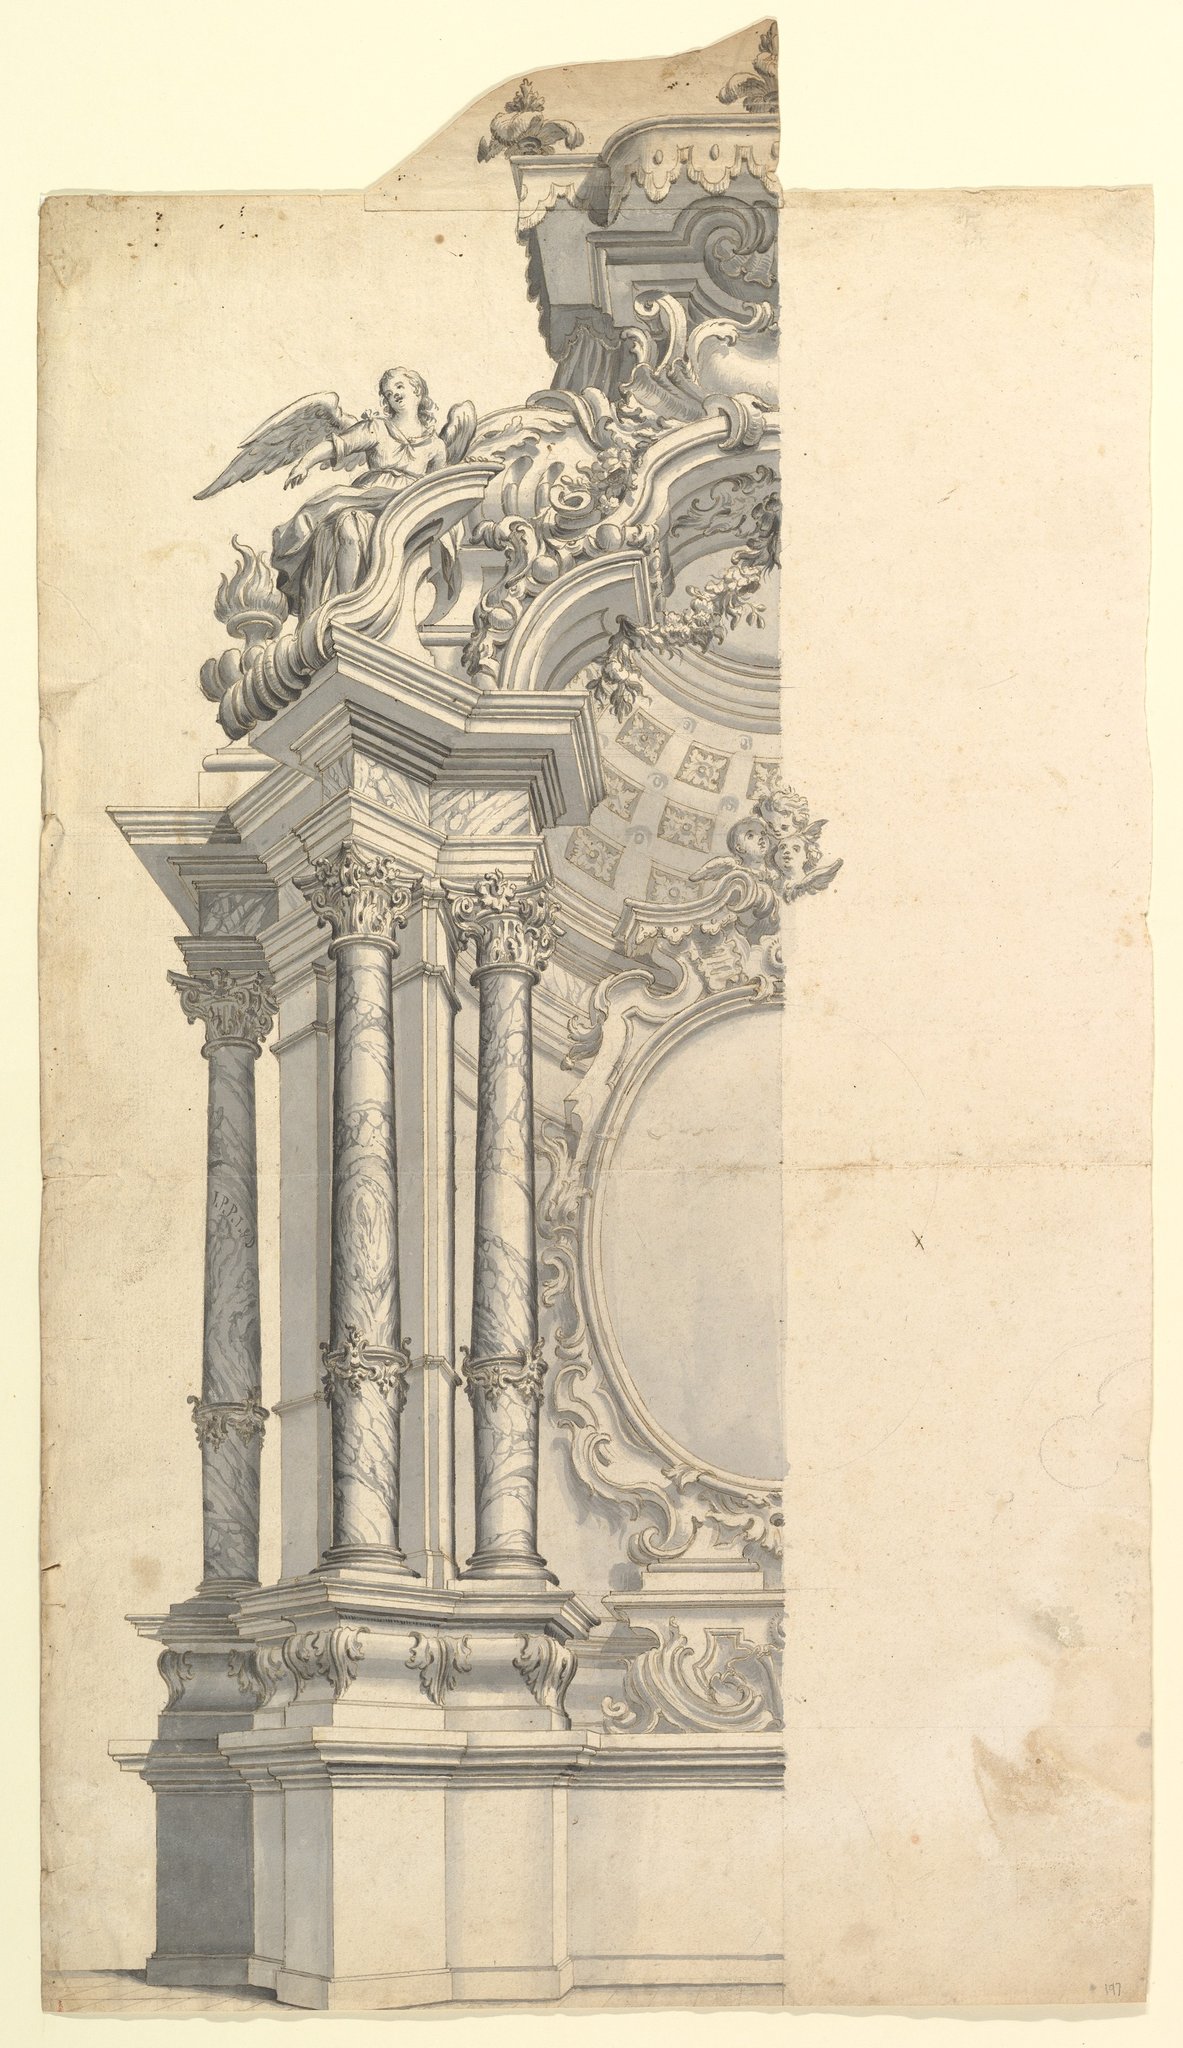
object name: drawing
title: Halved Design for an Altar with Angel and Putti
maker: anonymous, italian, piedmontese, 18th century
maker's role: artist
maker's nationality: italian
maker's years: 1700-1800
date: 1700-1780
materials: chalk, graphite, ink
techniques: brush, pen, wash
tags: altars,columns,angels